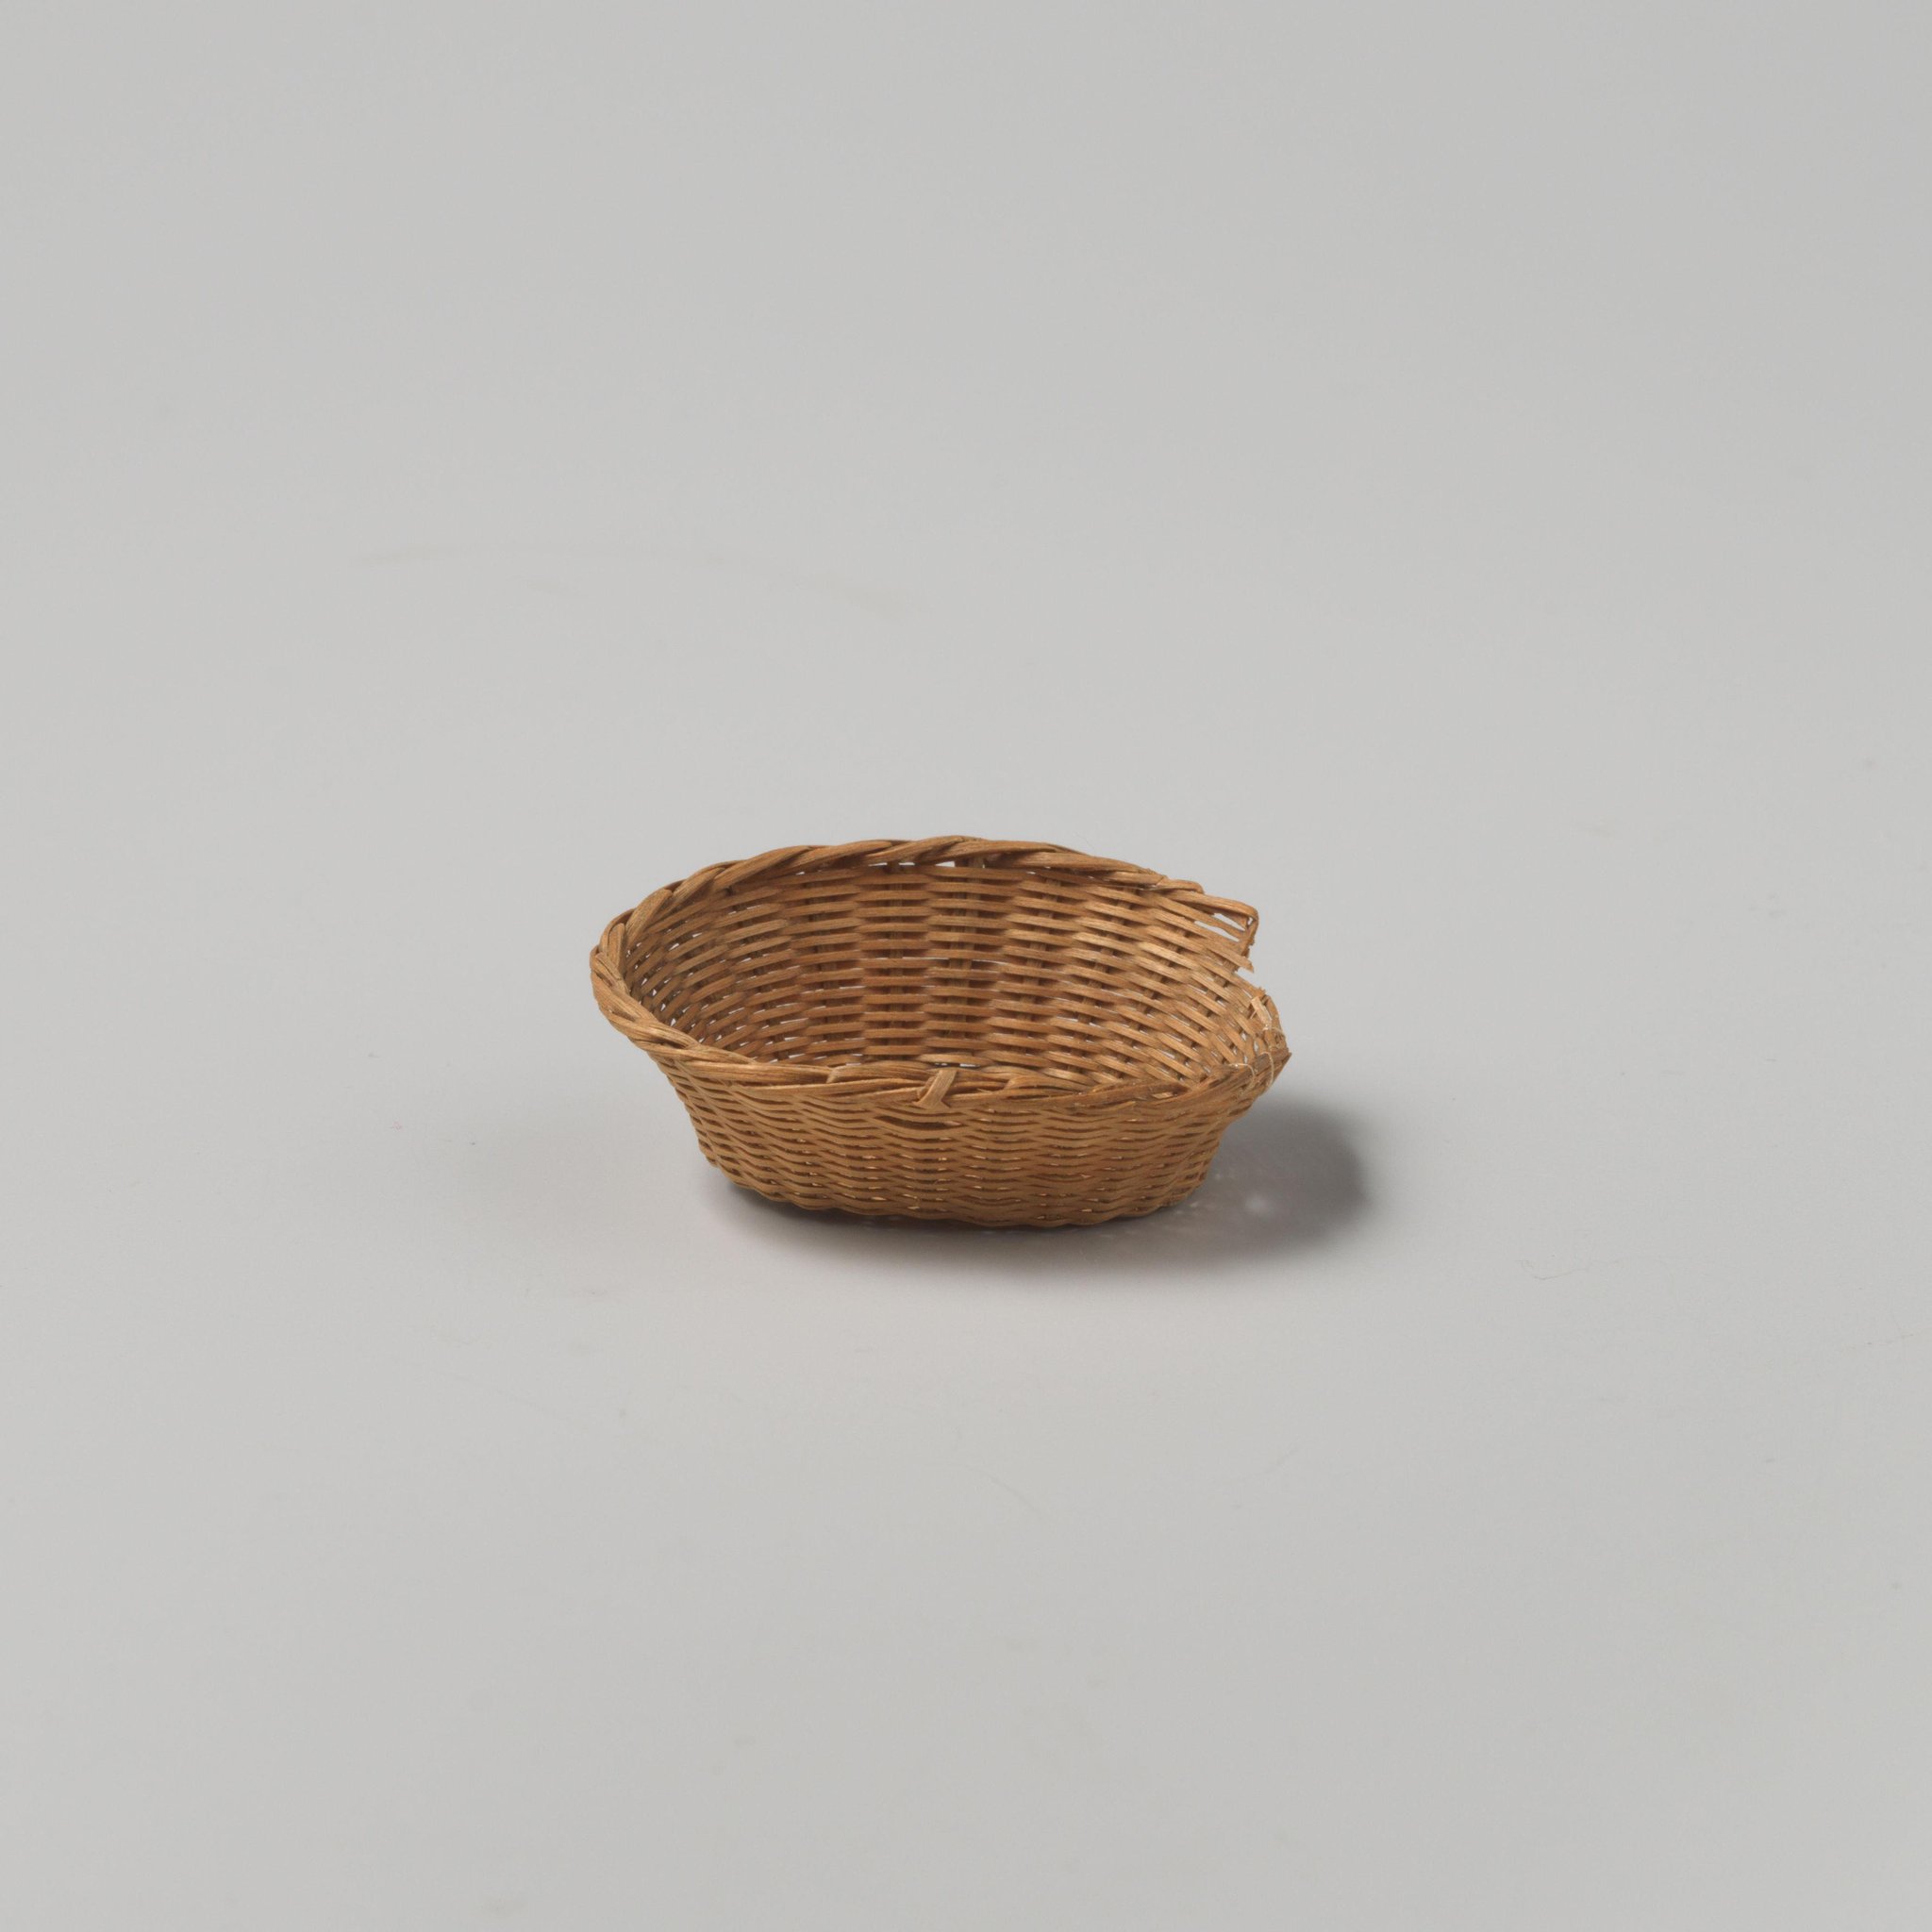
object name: basket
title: Mand vervaardigd van pitriet, met opstaande rand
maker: Anonymous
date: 1900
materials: rattan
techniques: pitriet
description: Mand vervaardigd van pitriet, met opstaande rand.